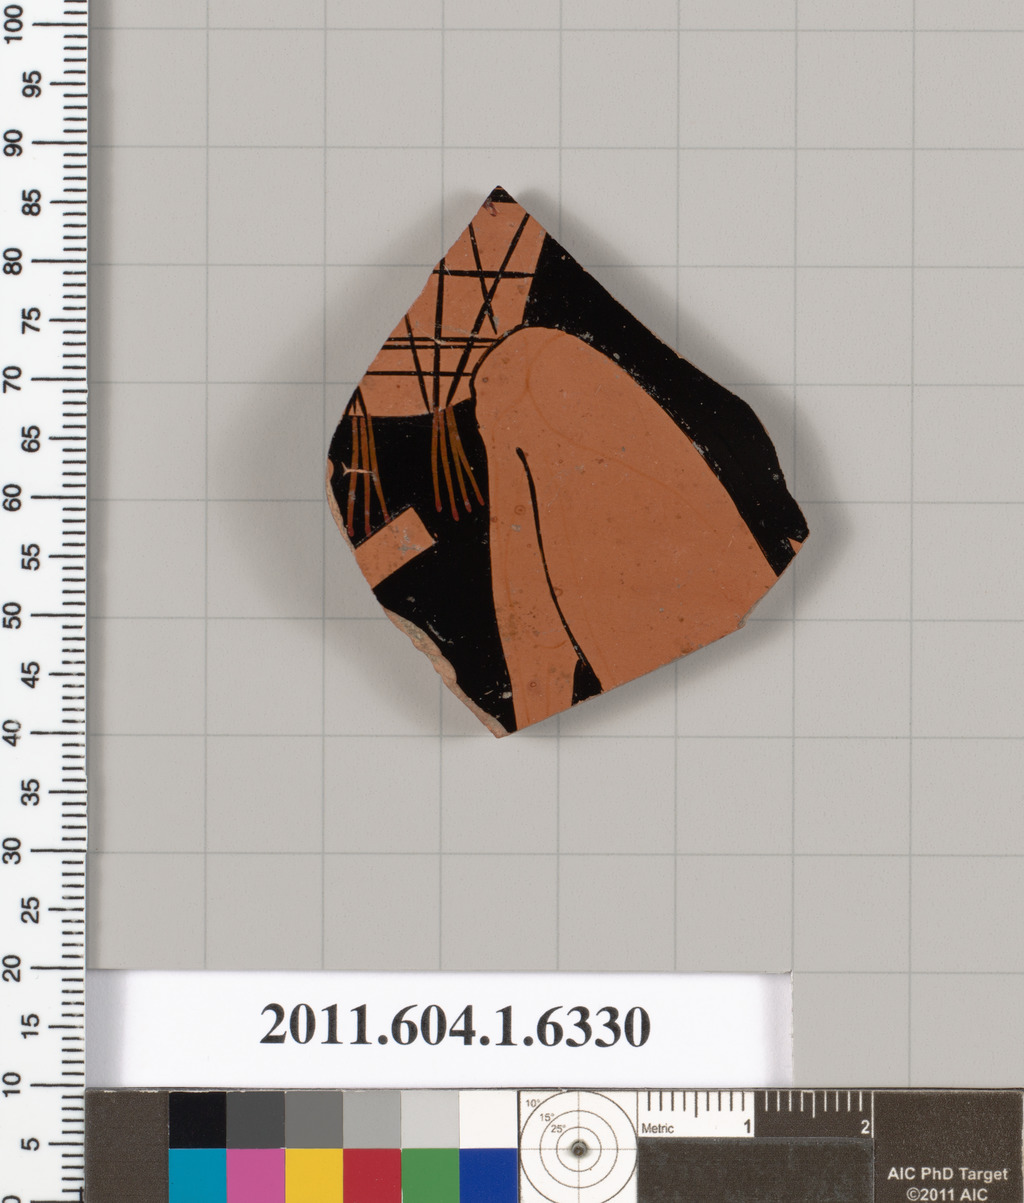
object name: kylix fragment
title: Terracotta fragment of a kylix (drinking cup)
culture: greek, attic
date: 500-480 BCE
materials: terracotta